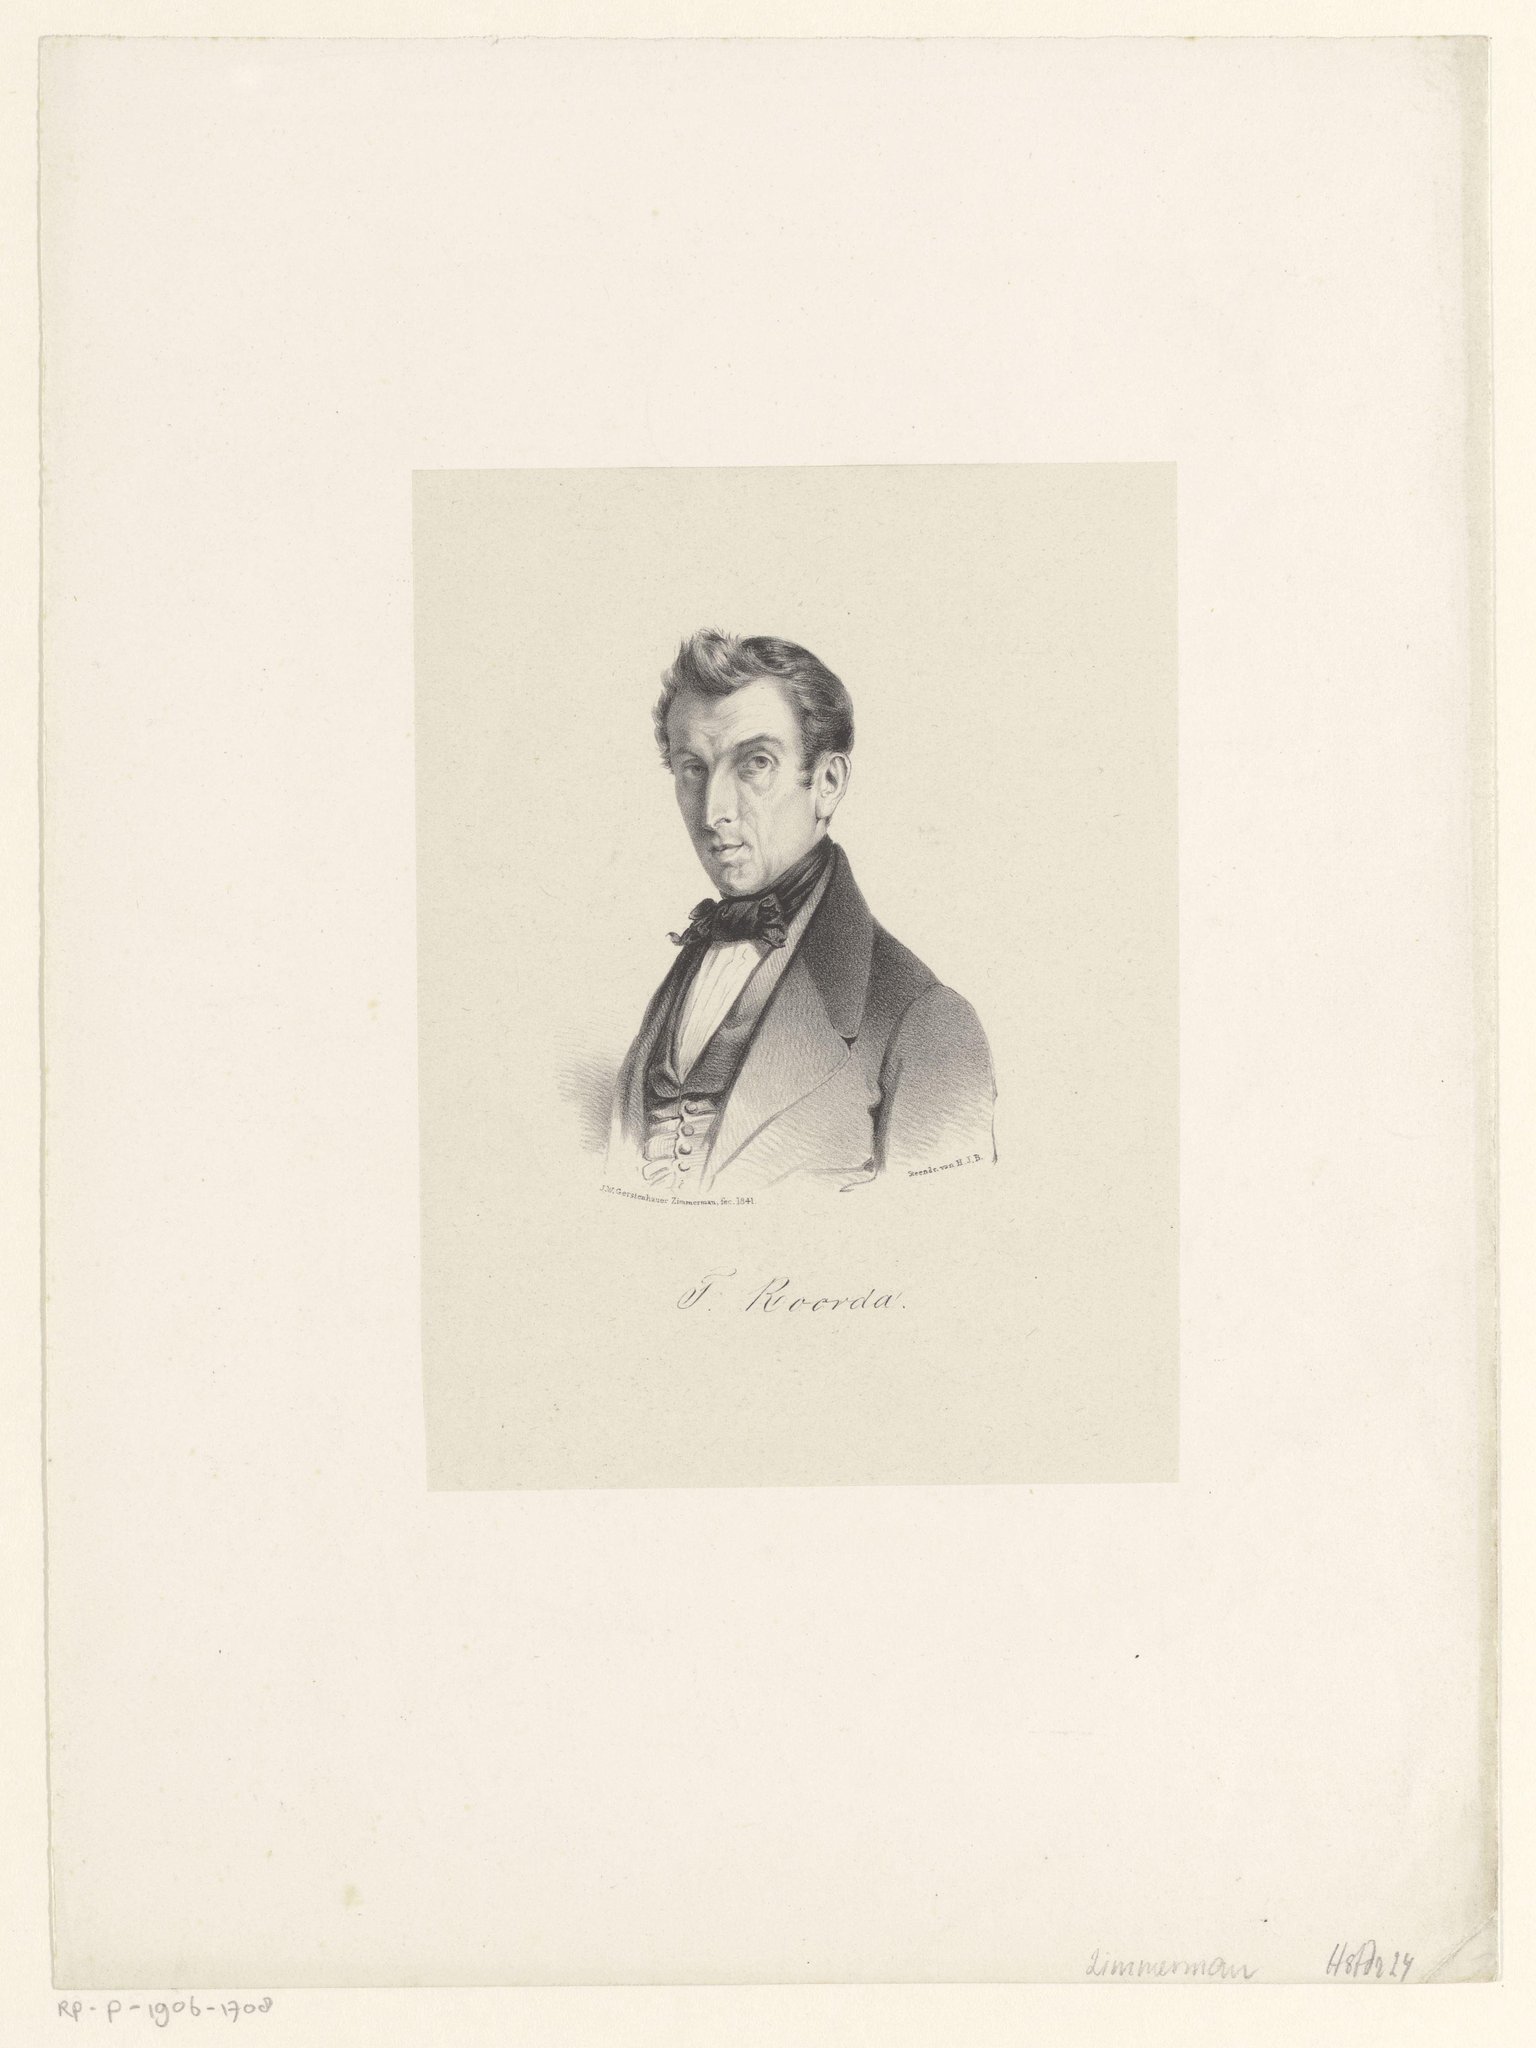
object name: print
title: Portret van Taco Roorda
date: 1841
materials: paper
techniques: lithograph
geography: dordrecht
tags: historical persons (+ (full) bust portrait)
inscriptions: collector's mark: Lugt 2228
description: Onder het portret de signatuur van de geportretteerde.